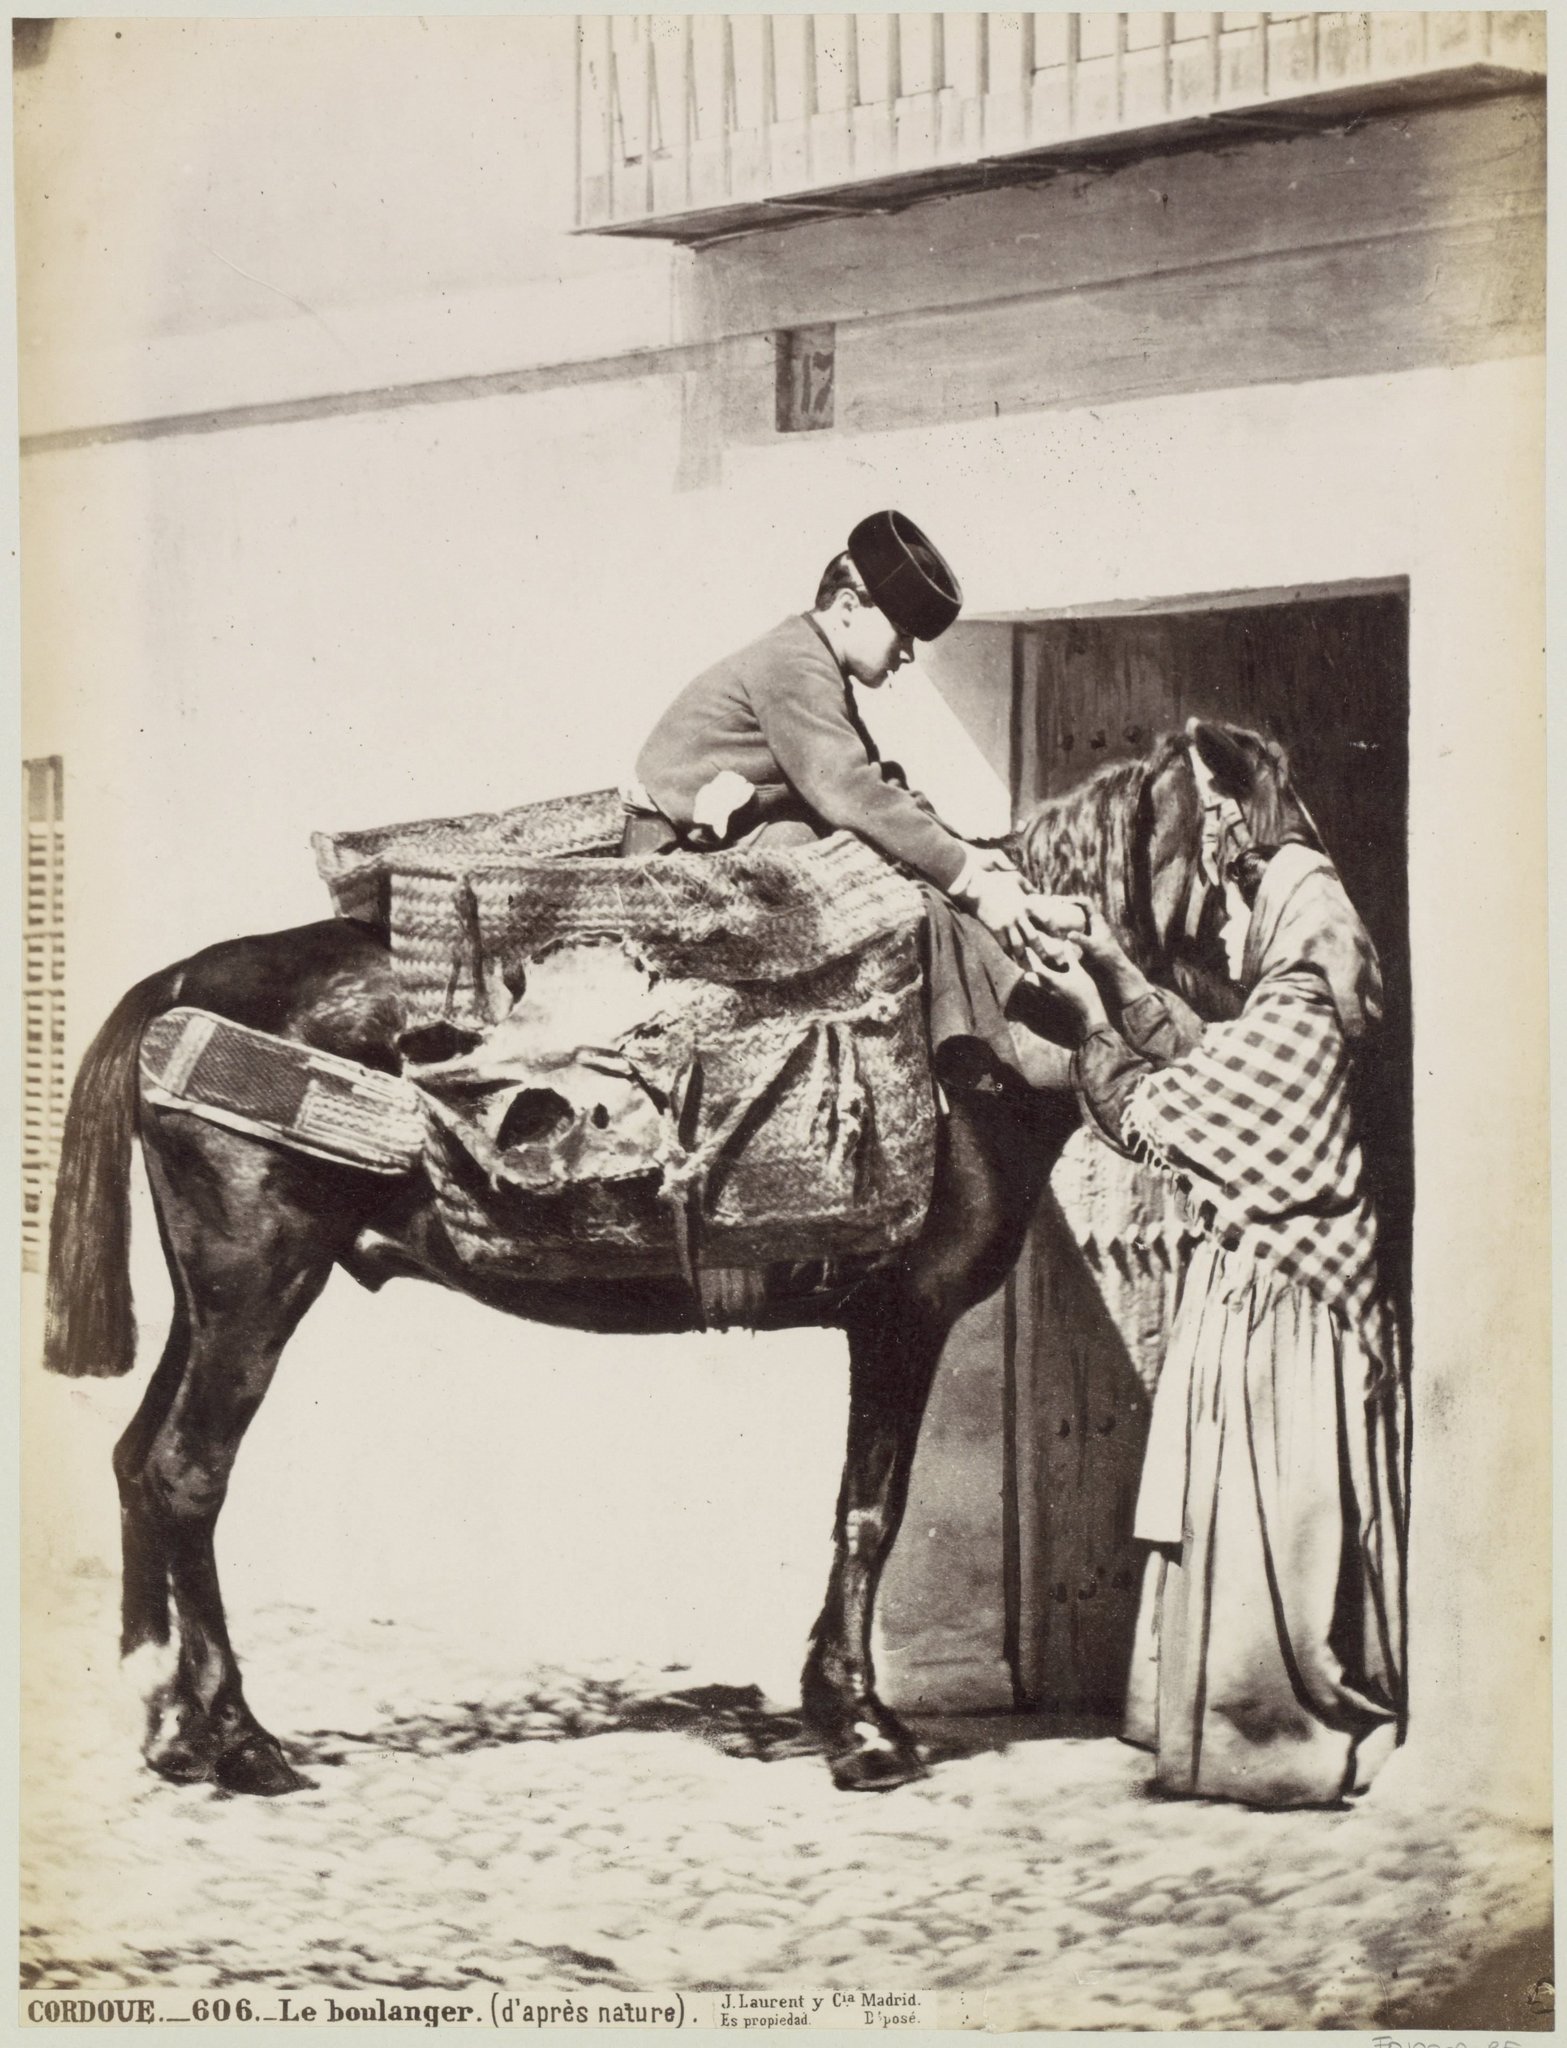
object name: photograph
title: Vrouw koopt brood van bakker te paard in Córdoba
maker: juan laurent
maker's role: publisher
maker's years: 1816-1896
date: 1857-1880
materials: cardboard, paper, photographic support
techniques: albumen print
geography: córdoba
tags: street-trader, horse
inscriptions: negative number: ‘606’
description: Onderdeel van Reisalbum met foto's van bezienswaardigheden in Spanje en Marokko.